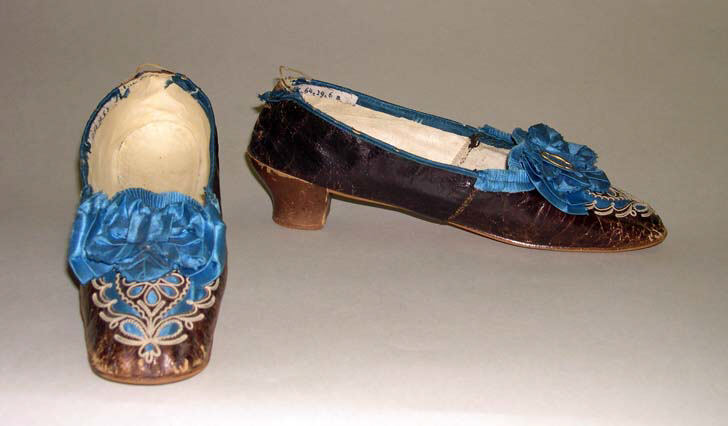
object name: slipper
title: Slippers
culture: american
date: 1850-1859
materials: leather